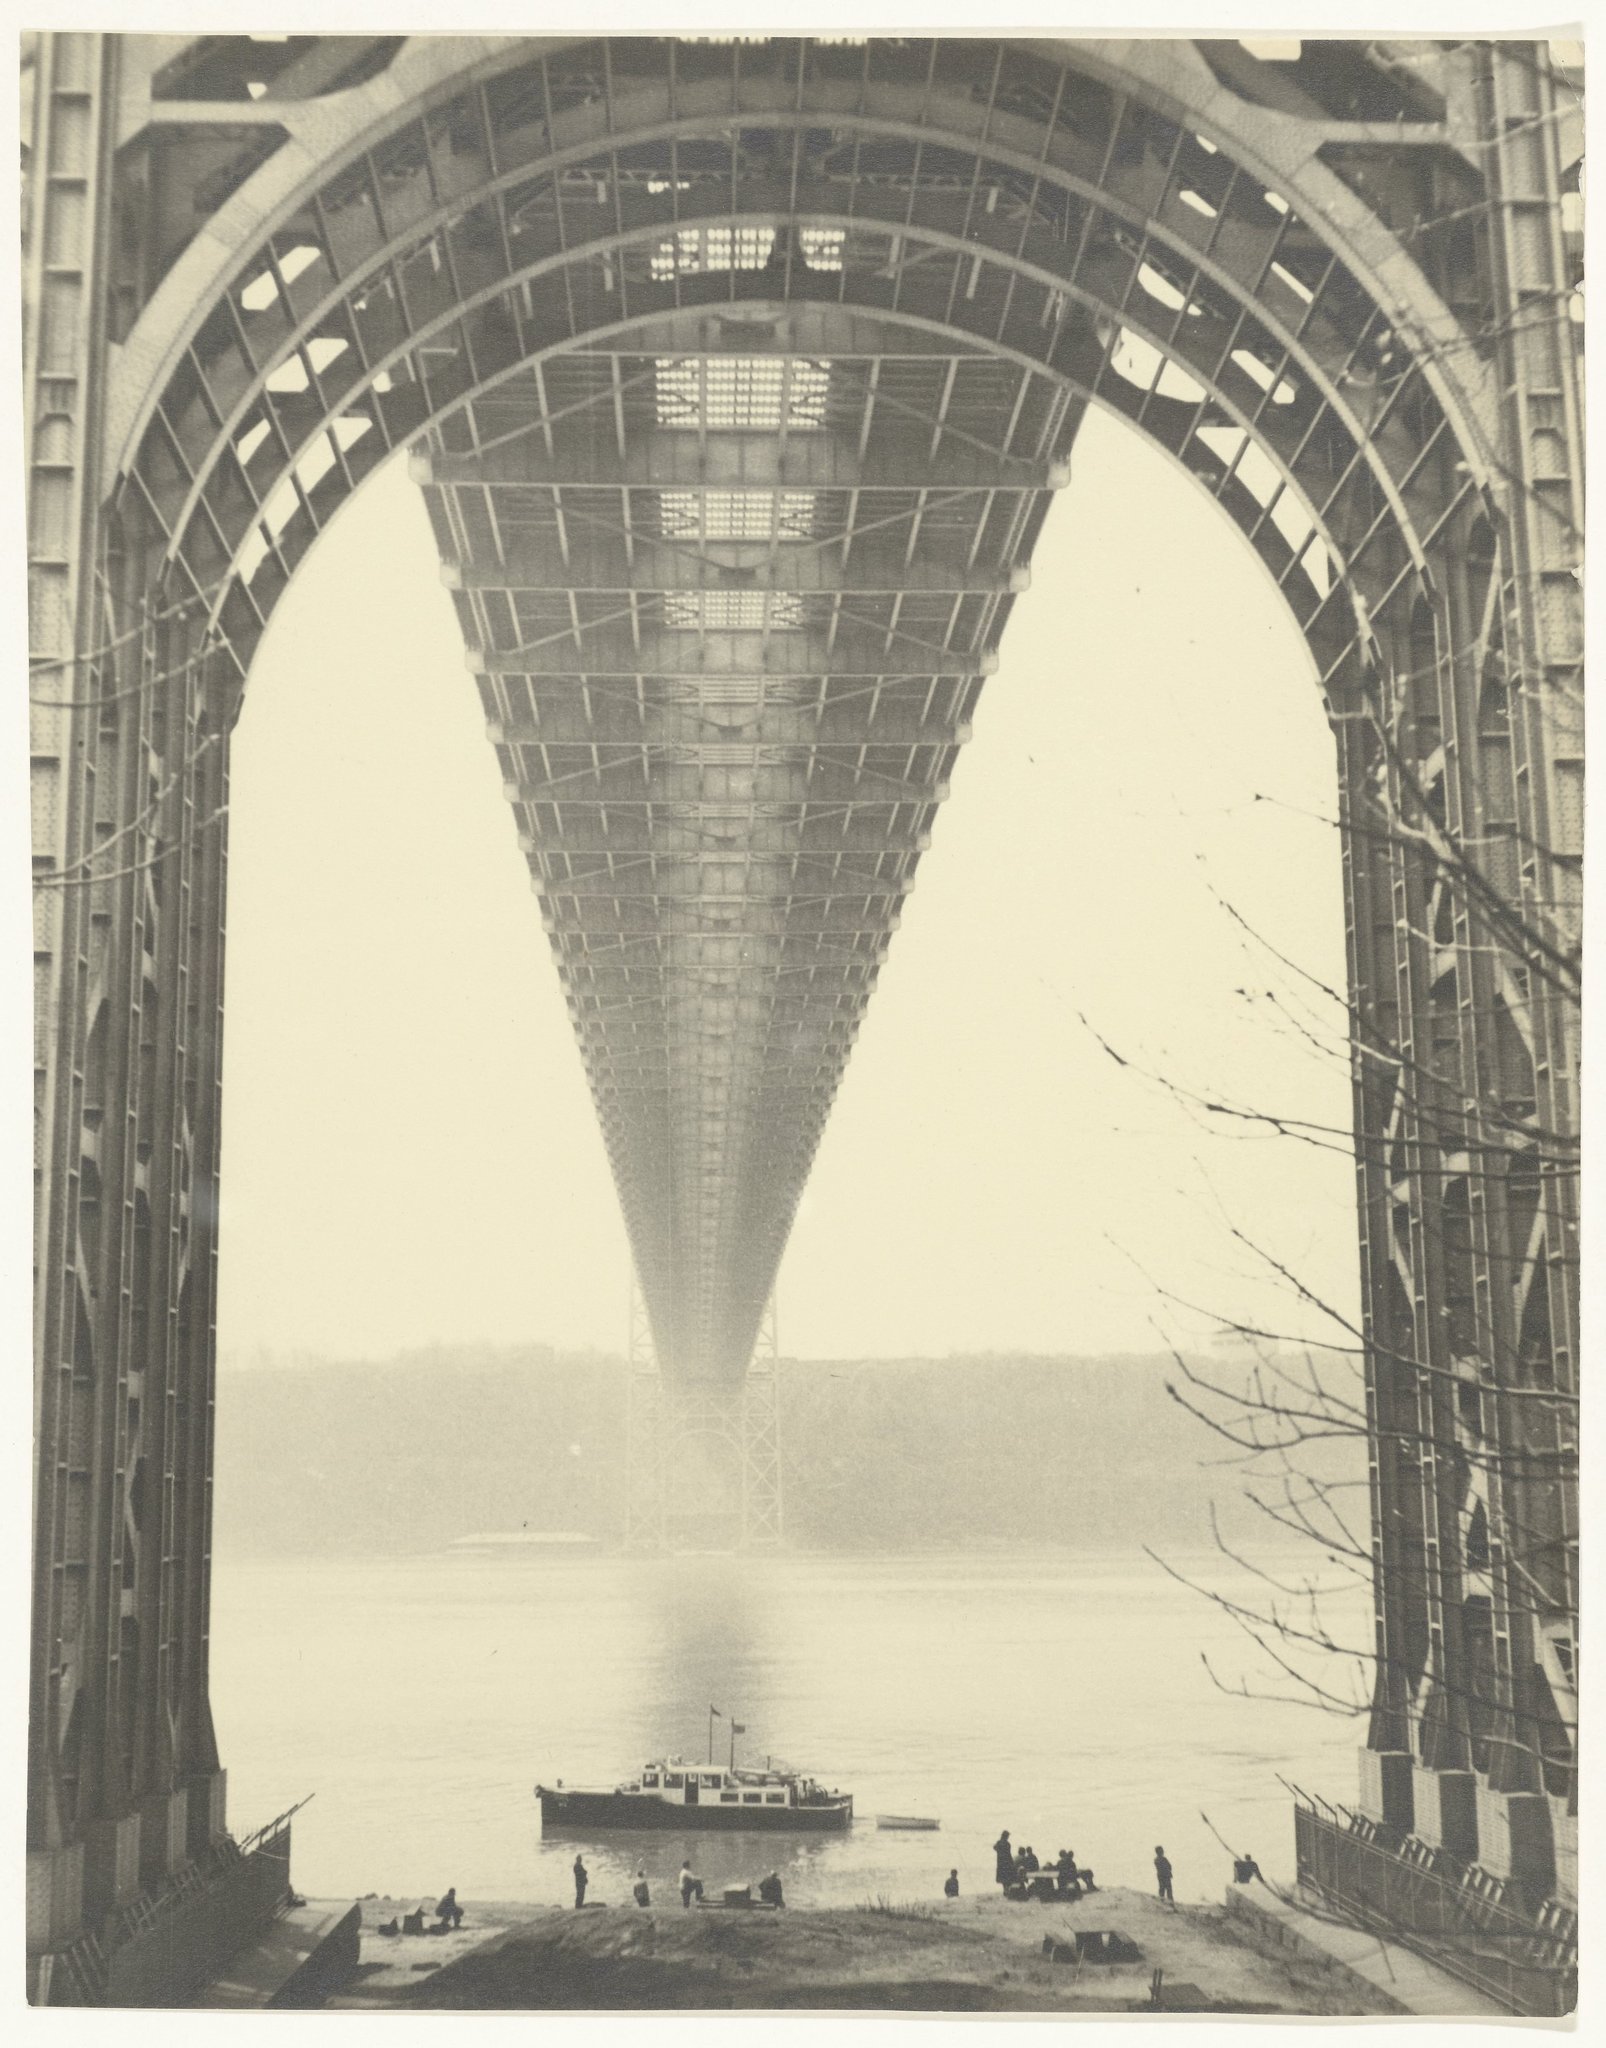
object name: photograph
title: Washington Bridge, New York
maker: herman anne marie cato dibbits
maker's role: engineer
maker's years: 1902-1988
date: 1939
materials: photographic support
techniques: gelatin silver print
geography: new york city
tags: bridge in city across river, canal, etc., new york (city)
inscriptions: annotation: ‘Foto / genomen / Maart/Mei / 1939 / Washington / Bridge / New / York’, annotation: ‘Foto genomen maart/mei 1939. / Washington-bridge, New York’